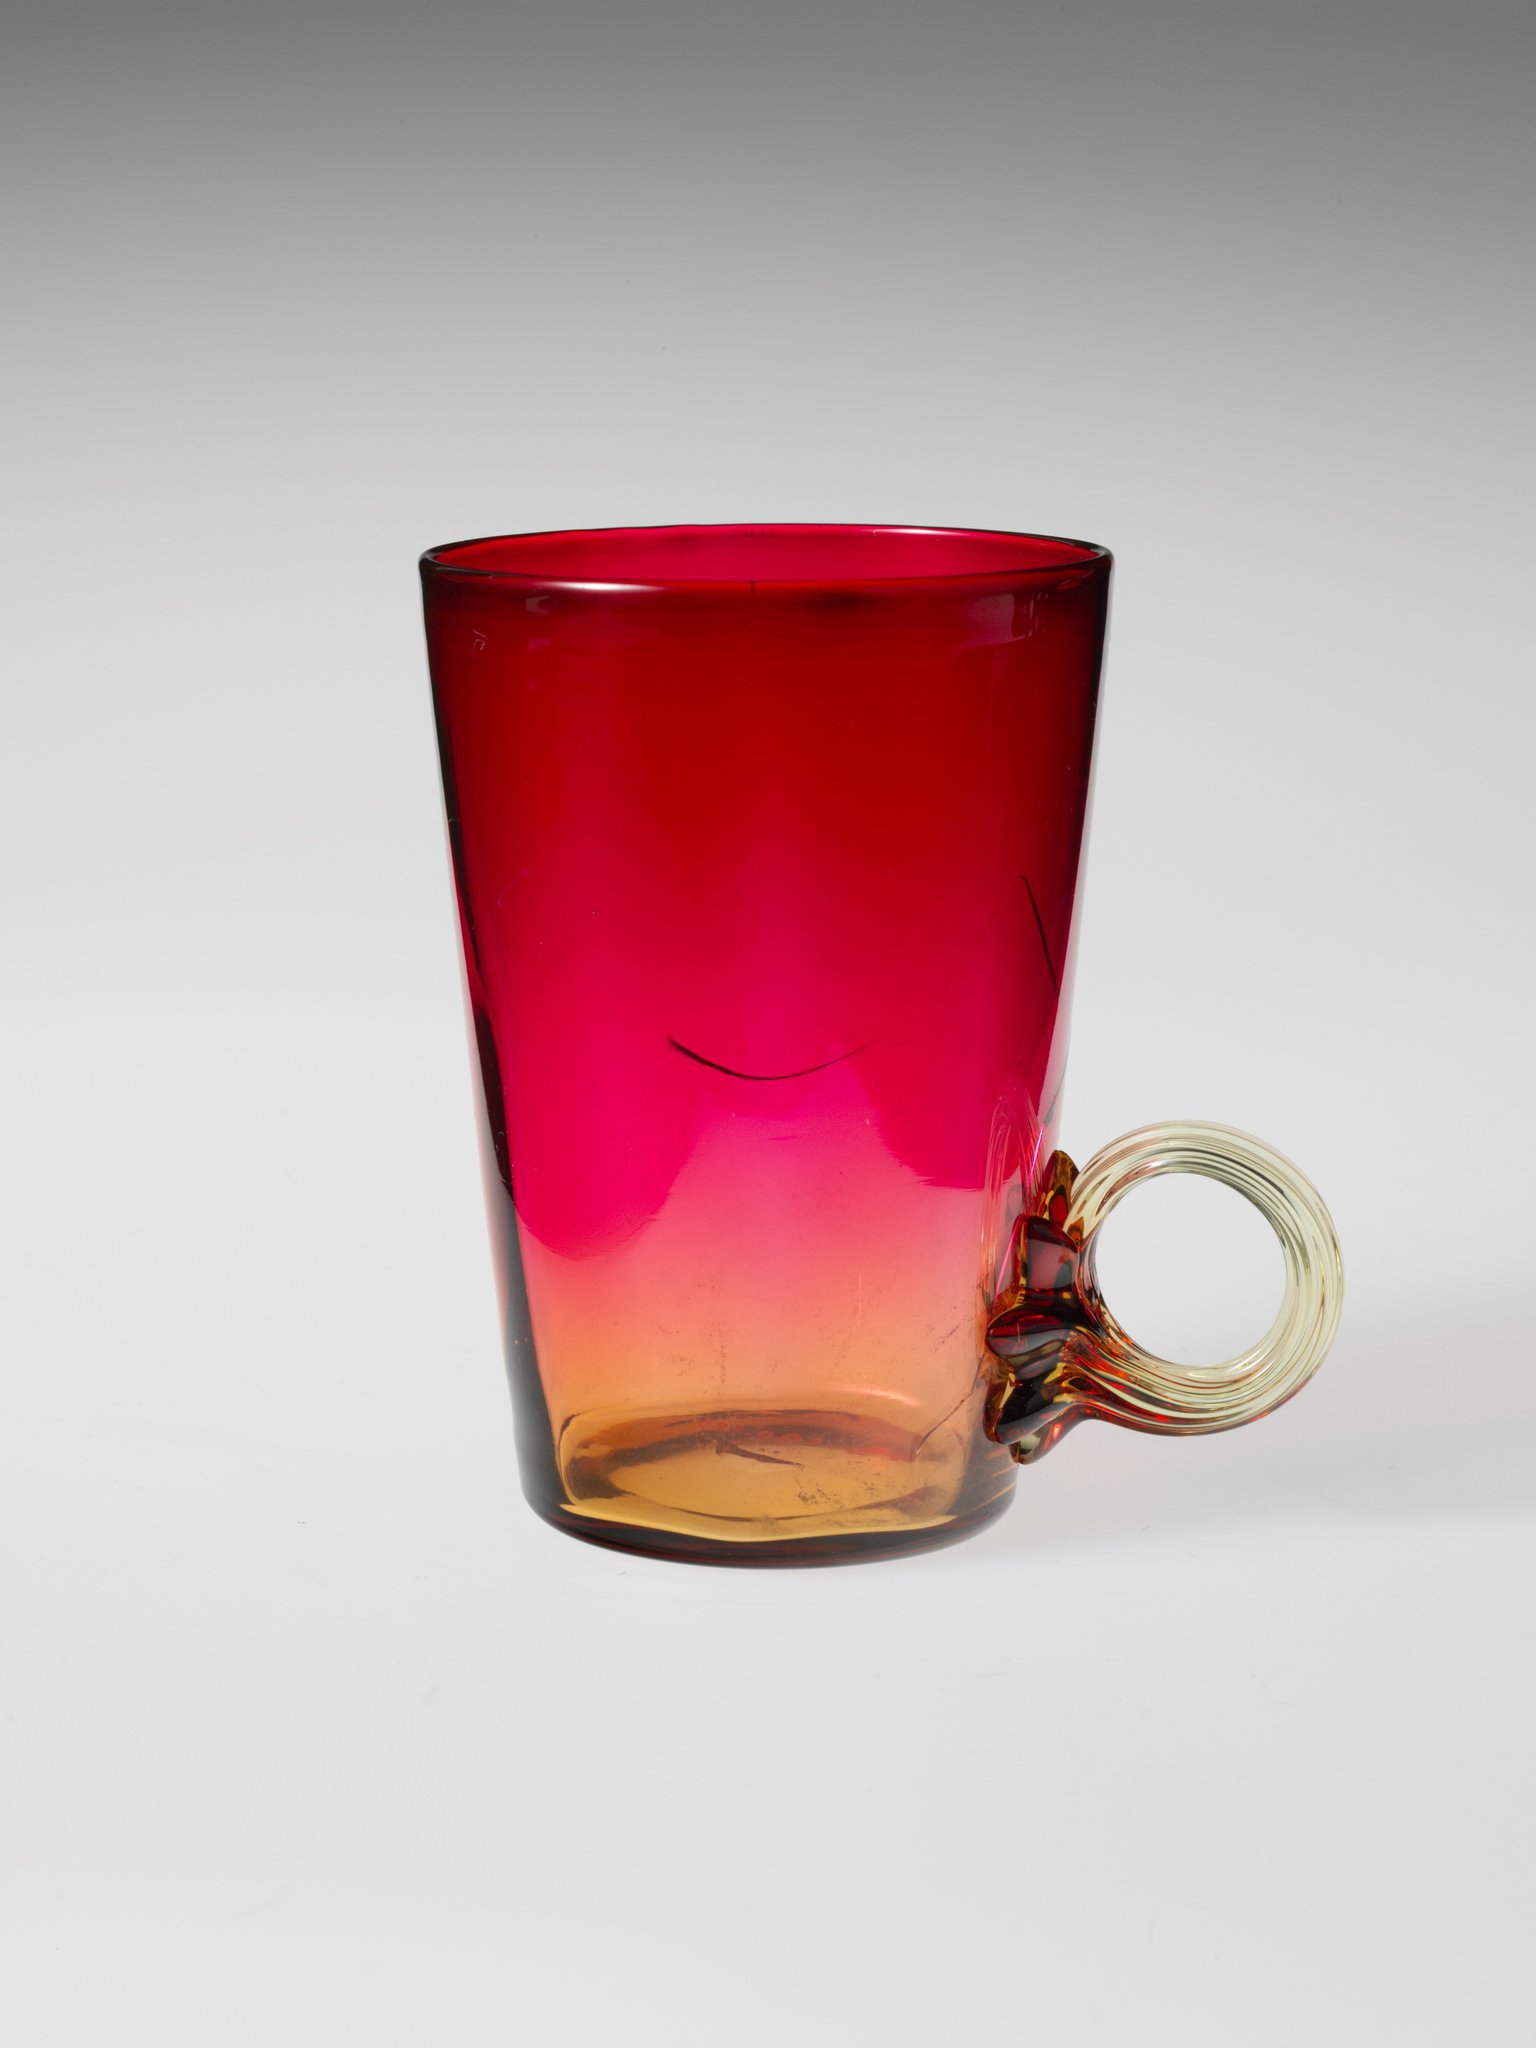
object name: punch glass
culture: american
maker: new england glass company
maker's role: maker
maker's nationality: american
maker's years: 1818-1888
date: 1883-1888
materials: glass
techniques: glassblowing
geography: united states